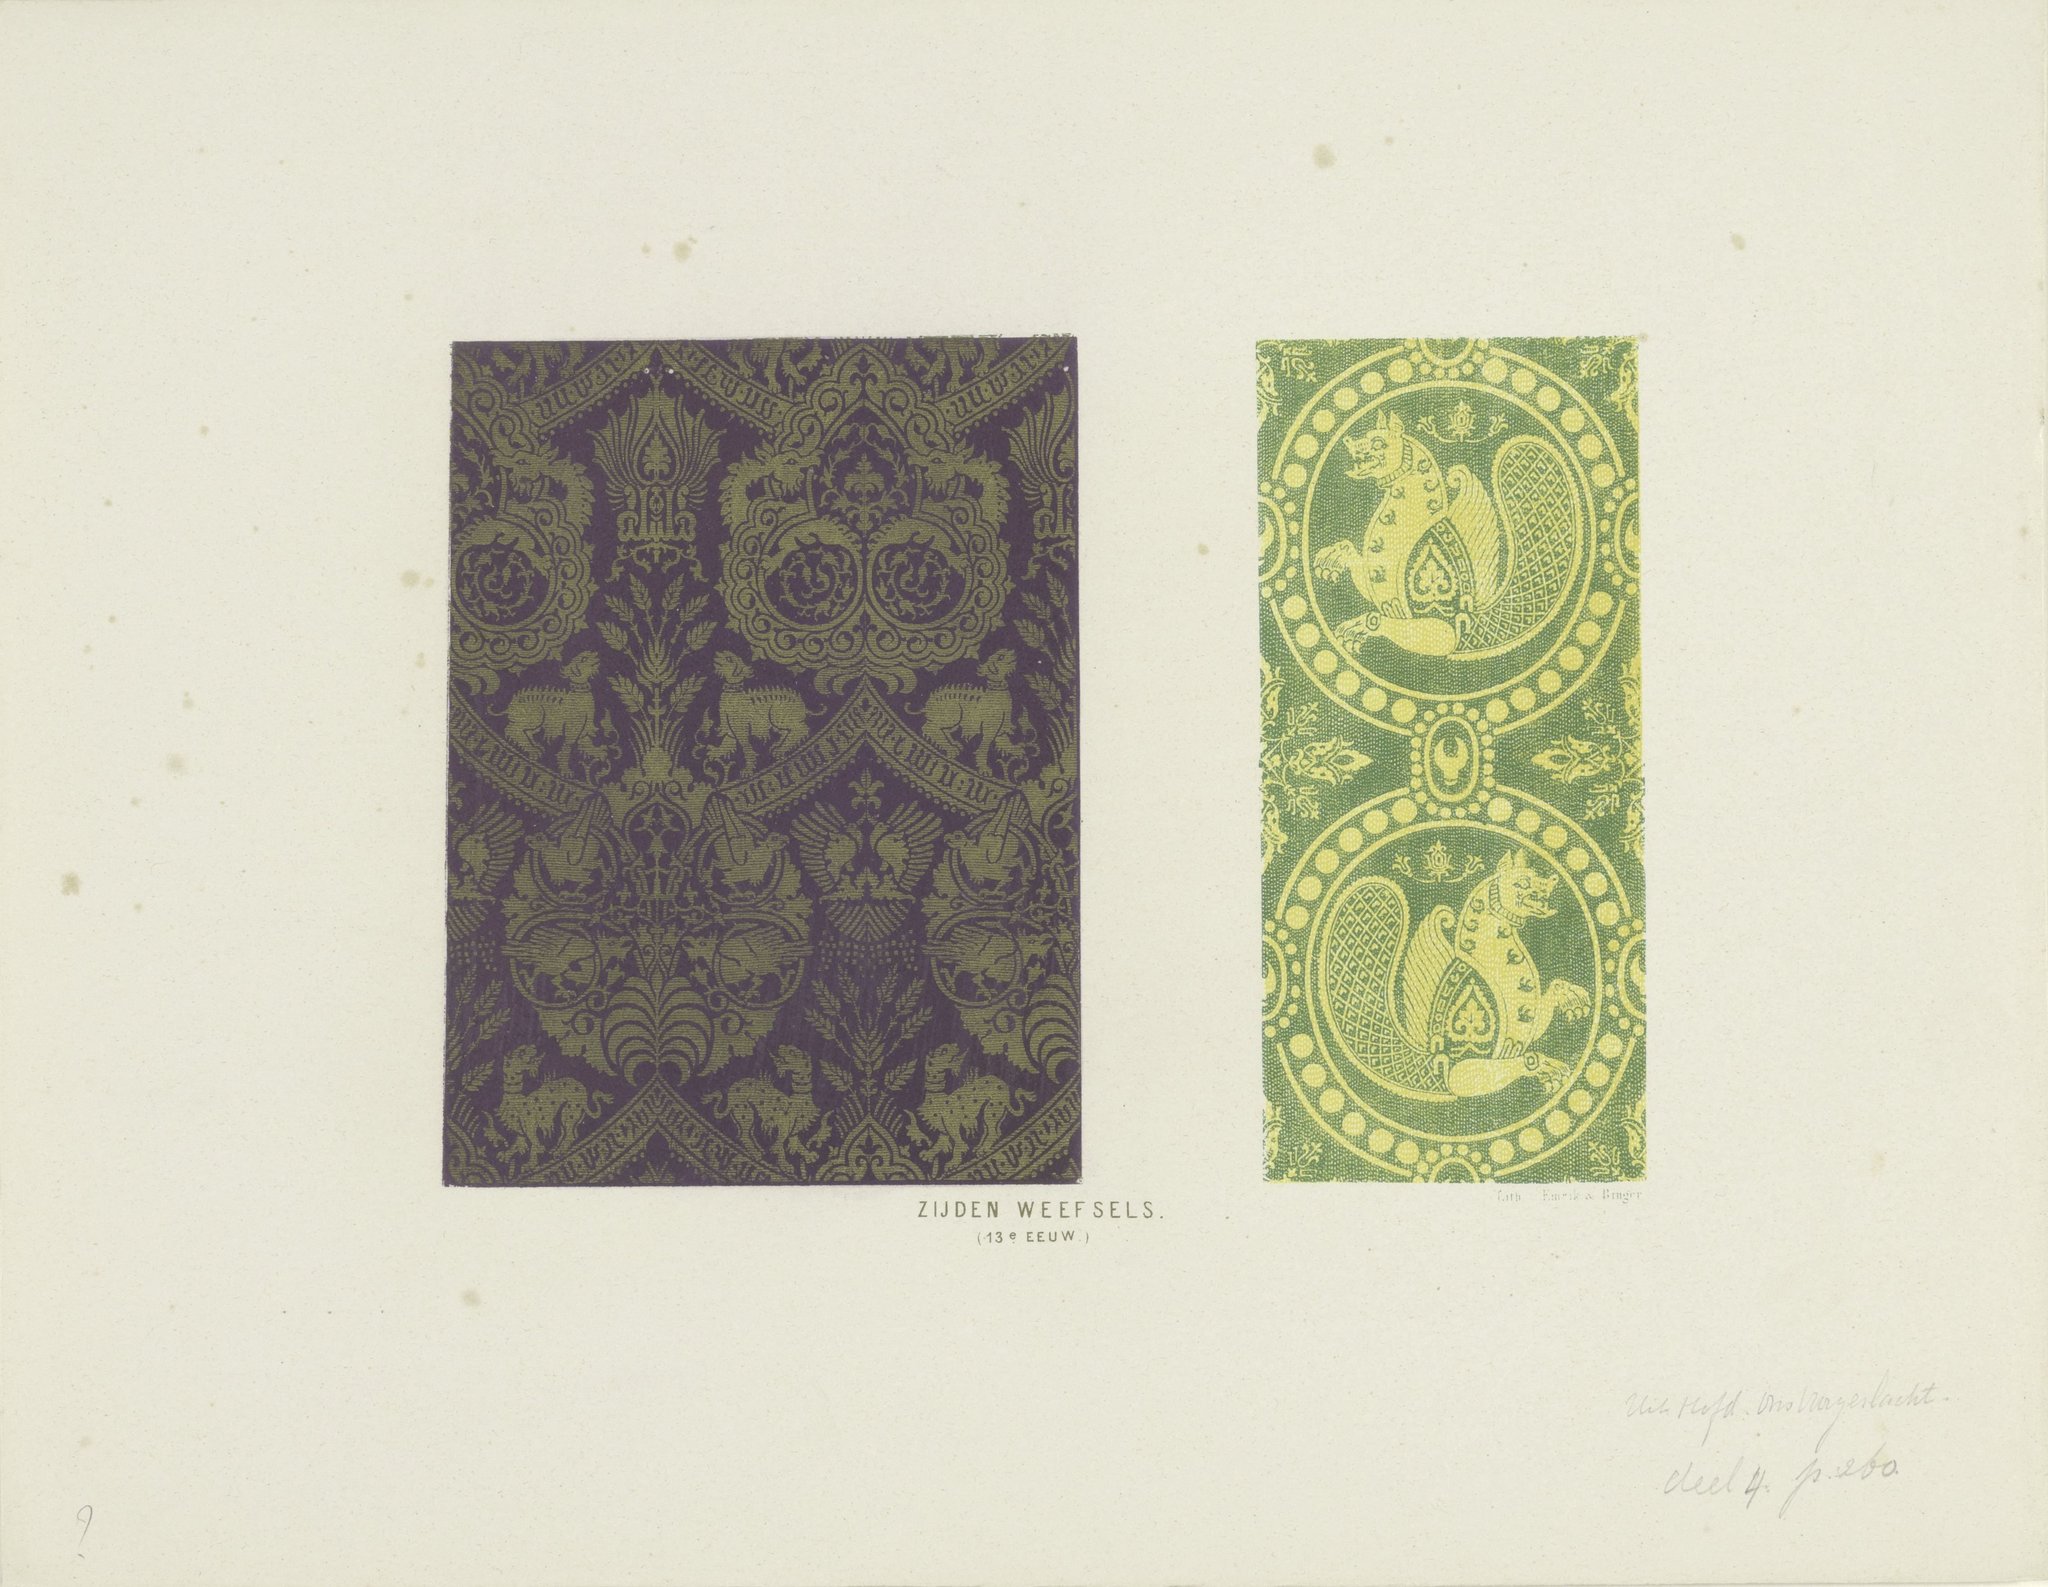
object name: historical object representation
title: Zijden weefsels. (13e eeuw)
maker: Anonymous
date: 1857-1864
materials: paper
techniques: chromolithography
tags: textile fabric, cloth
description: Illustratie voor: W.J. Hofdijk, Ons voorgeslacht in zijn dagelyksch leven geschilderd, Kruseman, Haarlem 1859-1864, dl. 4, p. 260.